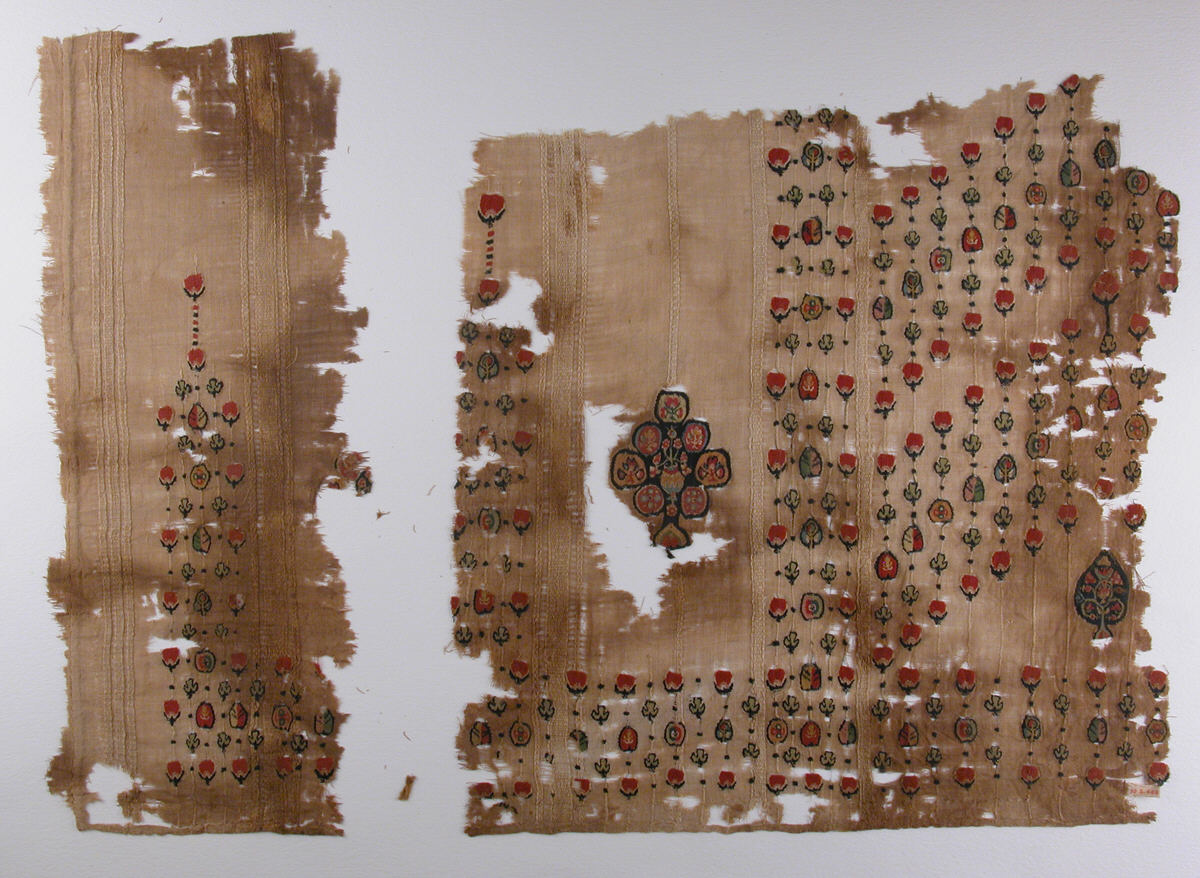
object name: textile fragment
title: Fragment with Scattered Pattern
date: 501-800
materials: linen, wool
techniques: weave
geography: egypt